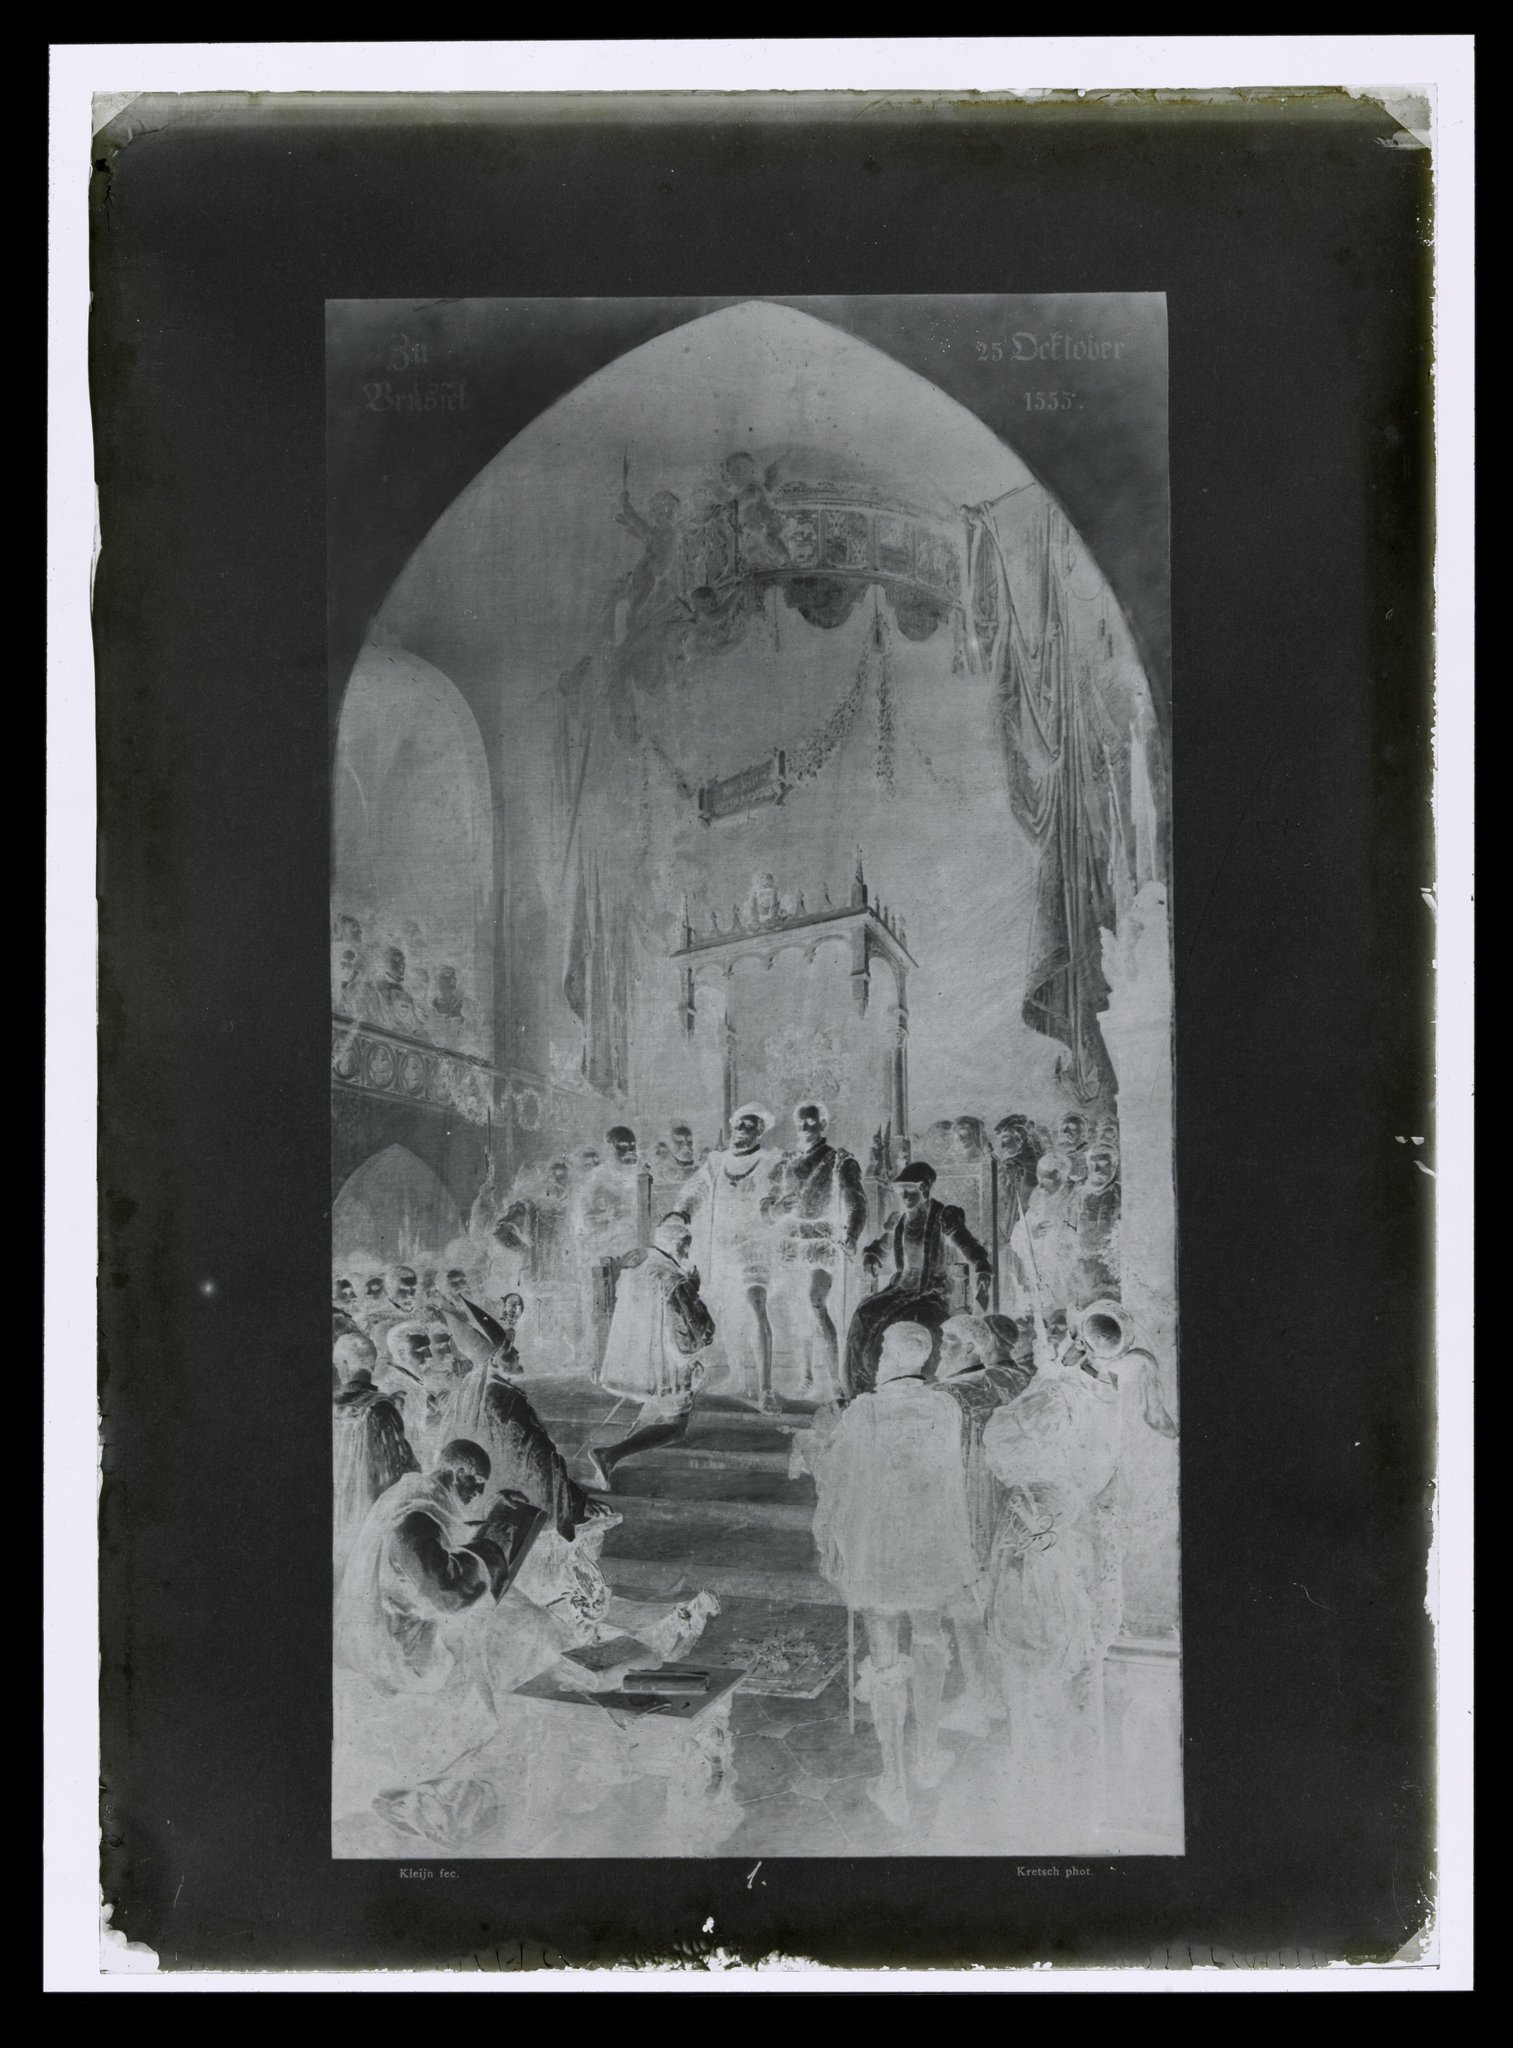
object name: reproduction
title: Zu Brussel, 15 October 1555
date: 1865-1900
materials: glass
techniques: collodion process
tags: abdication (of a ruler)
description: Onderdeel van een groep glasnegatieven uit de nalatenschap van de schilder Laurens Lodewijk Kleijn, met stillevens, portretten, zelfportretten en kunstreproducties.